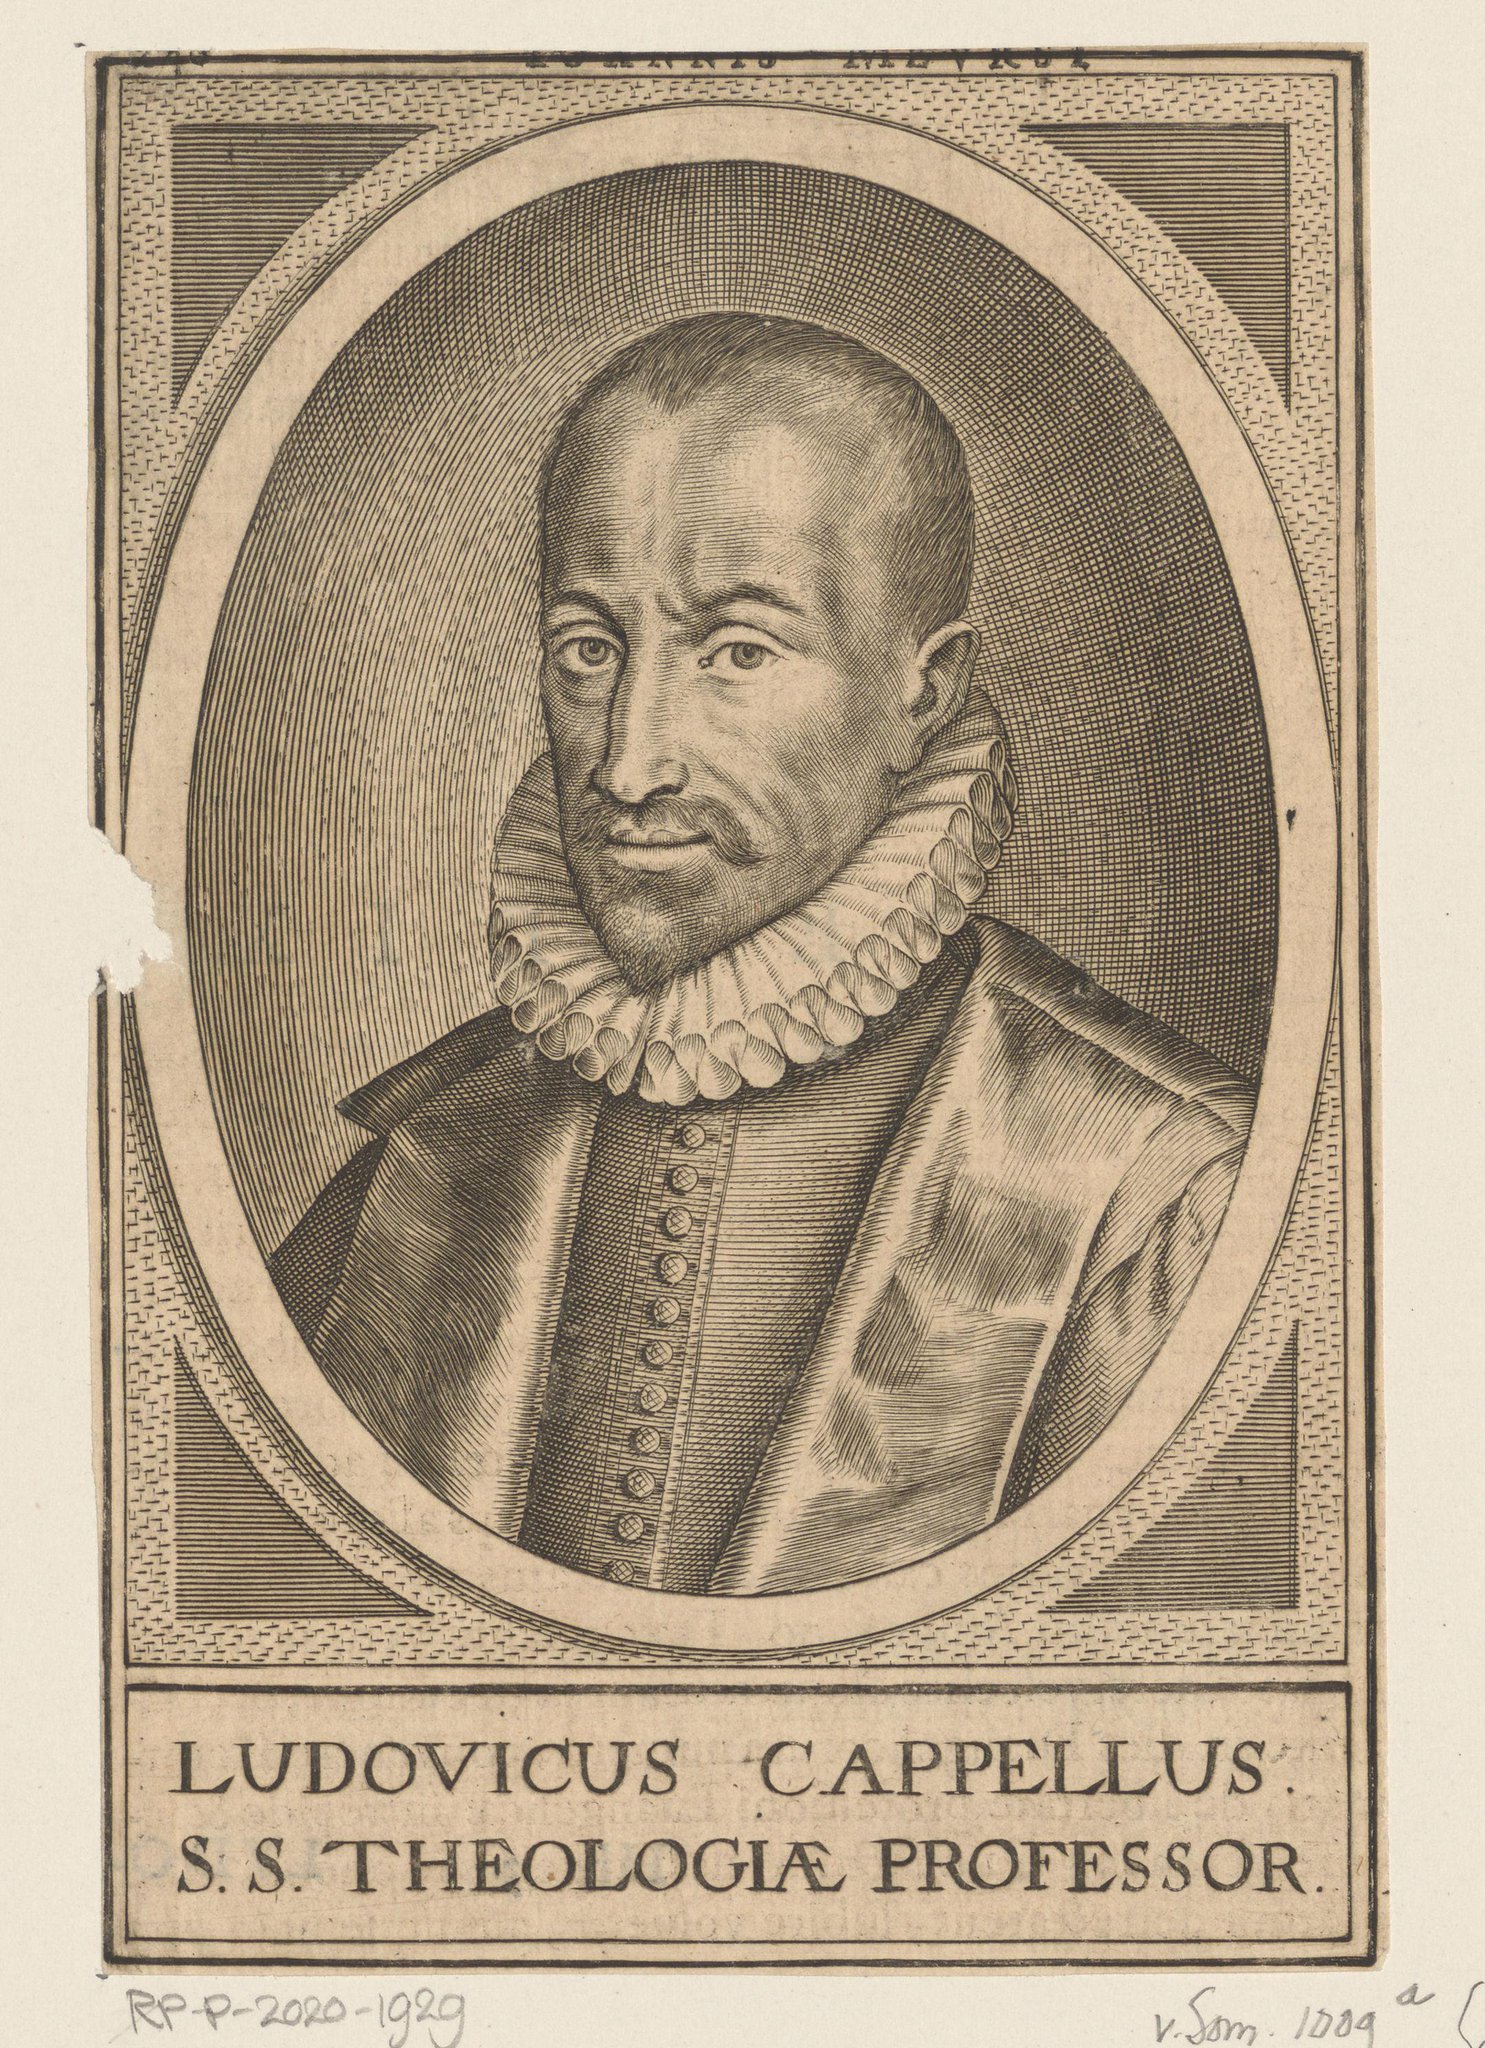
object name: book illustration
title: Portret van Lodewijk Cappellus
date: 1715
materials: ink, paper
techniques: engraving, letterpress printing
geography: leiden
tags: paris, historical persons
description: Prent uit: Meurs, Johannes van. Athenae Batavae (...). Leiden: Andries Clouck, Abraham Elzevier I en Bonaventura Elzevier, 1715.